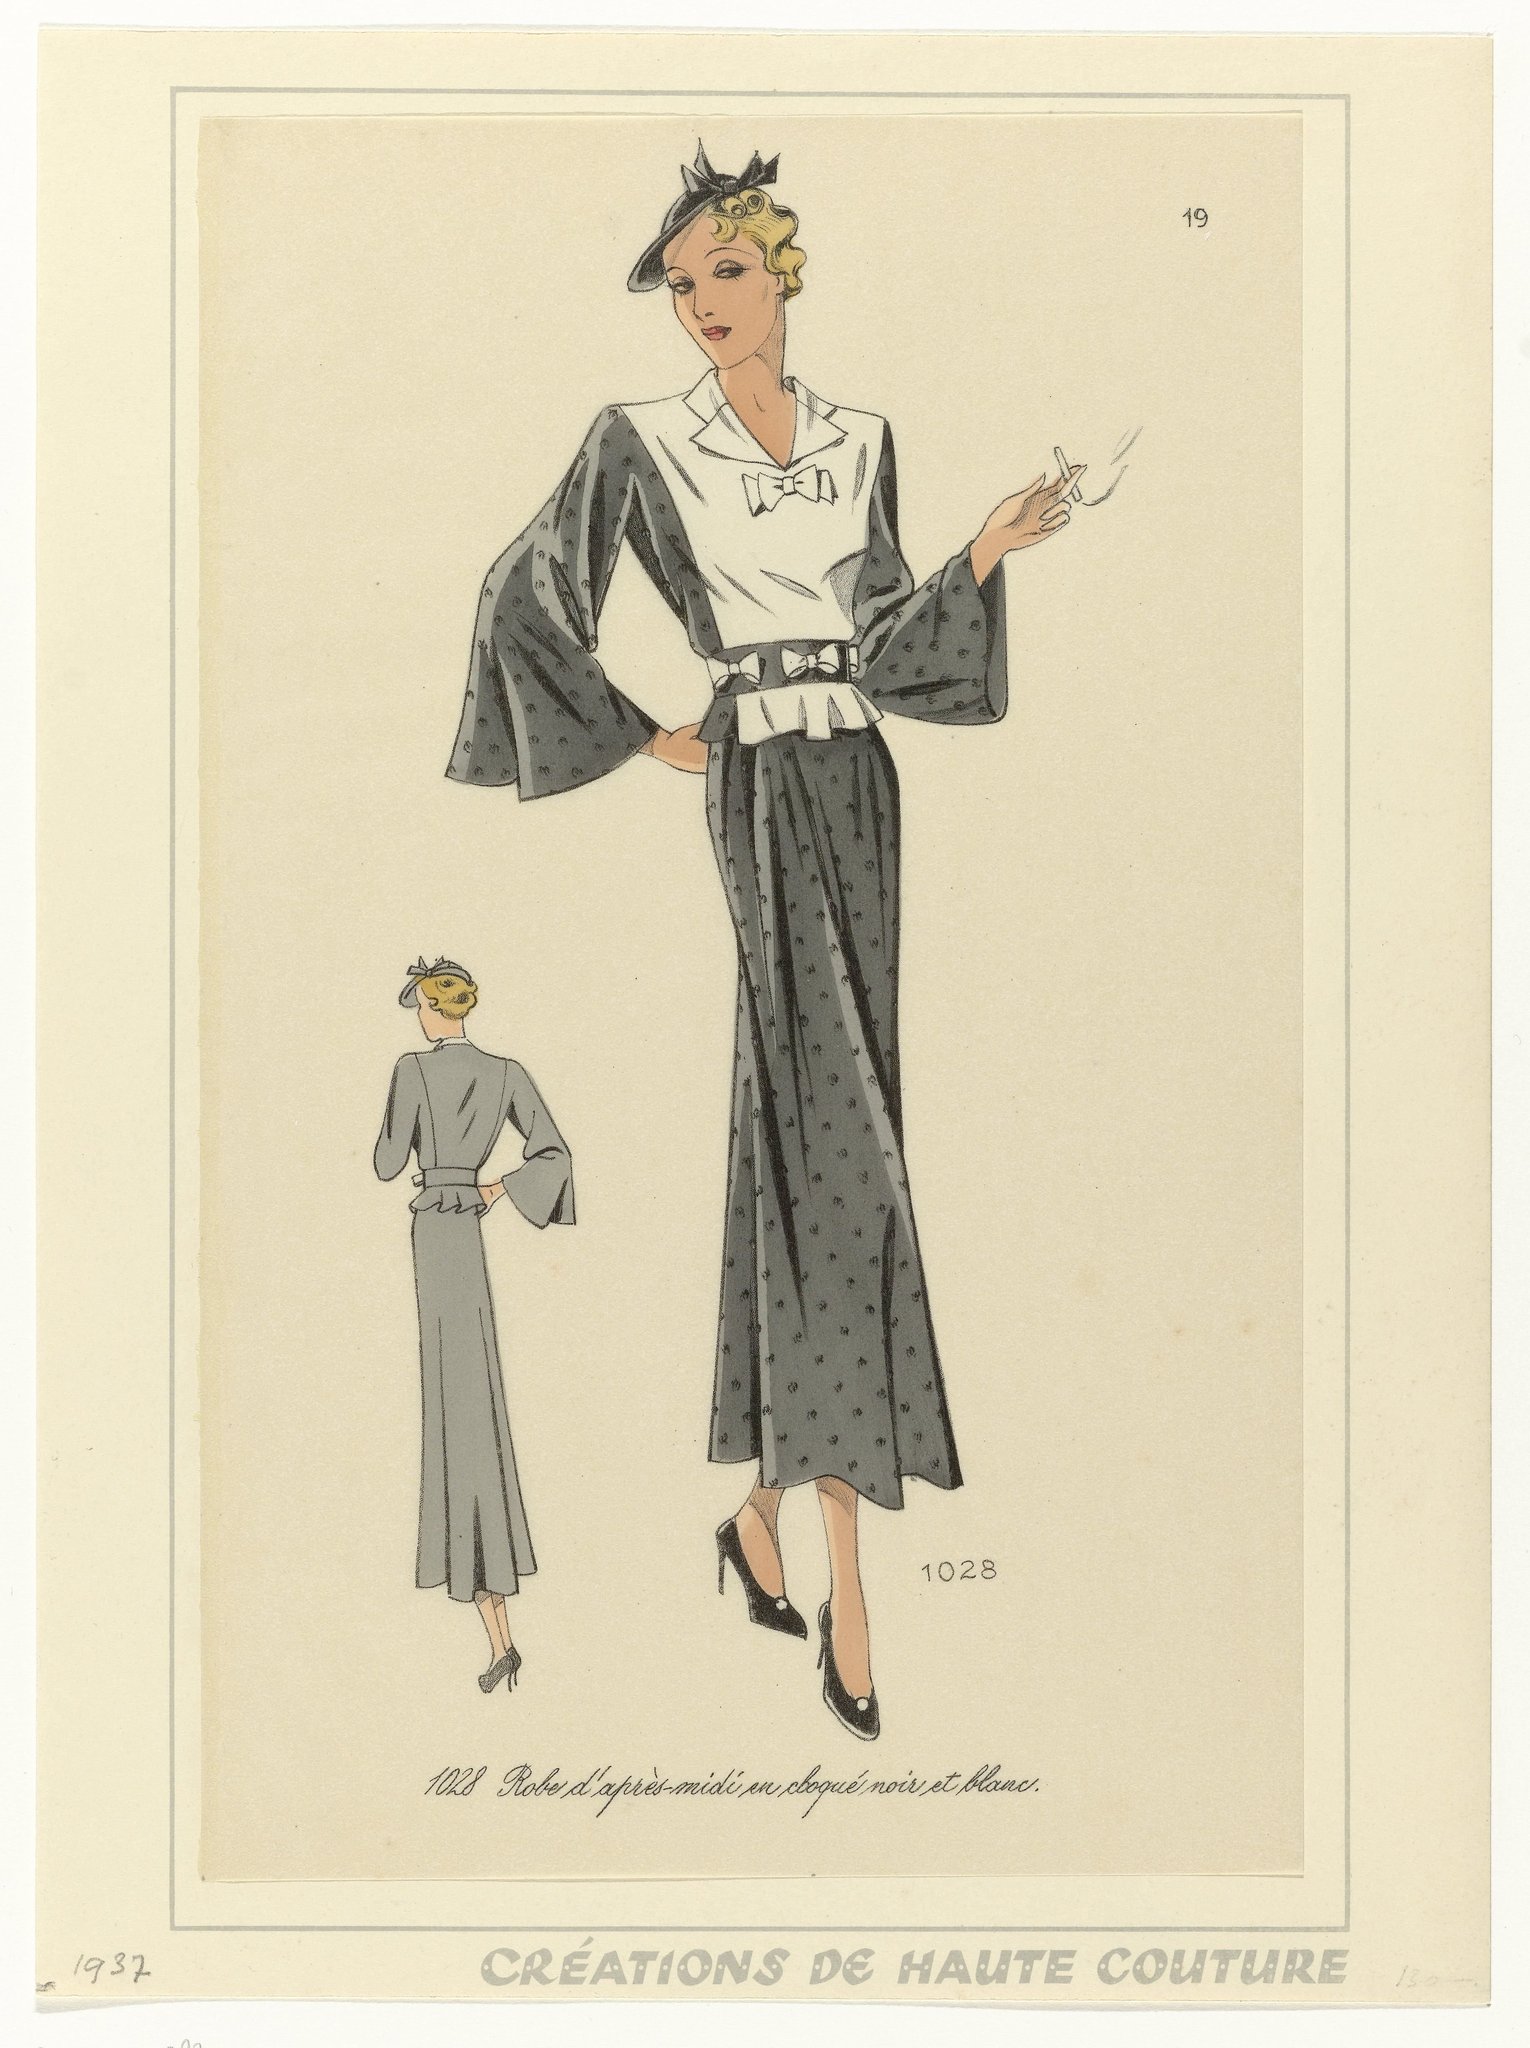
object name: fashion print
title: Créations de Haute Couture, No. 1028, No. 19 : Robe d'après-mid (...)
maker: Anonymous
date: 1937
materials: paper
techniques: hand coloring, lithograph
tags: head-gear (+ women's clothes), fashion plates, dress, gown (+ women's clothes), cigarette (+ taking (particular) foodstuffs: eating, drinking, smoking, chewing, etc.)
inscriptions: title: ‘Créations de Haute Couture’, caption: ‘1028 Robe d'après-midi en cloqué noir et blanc’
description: Zwarte middagjapon met wit lijfje. Plat hoedje op het korte kapsel. Sigaret in de hand.